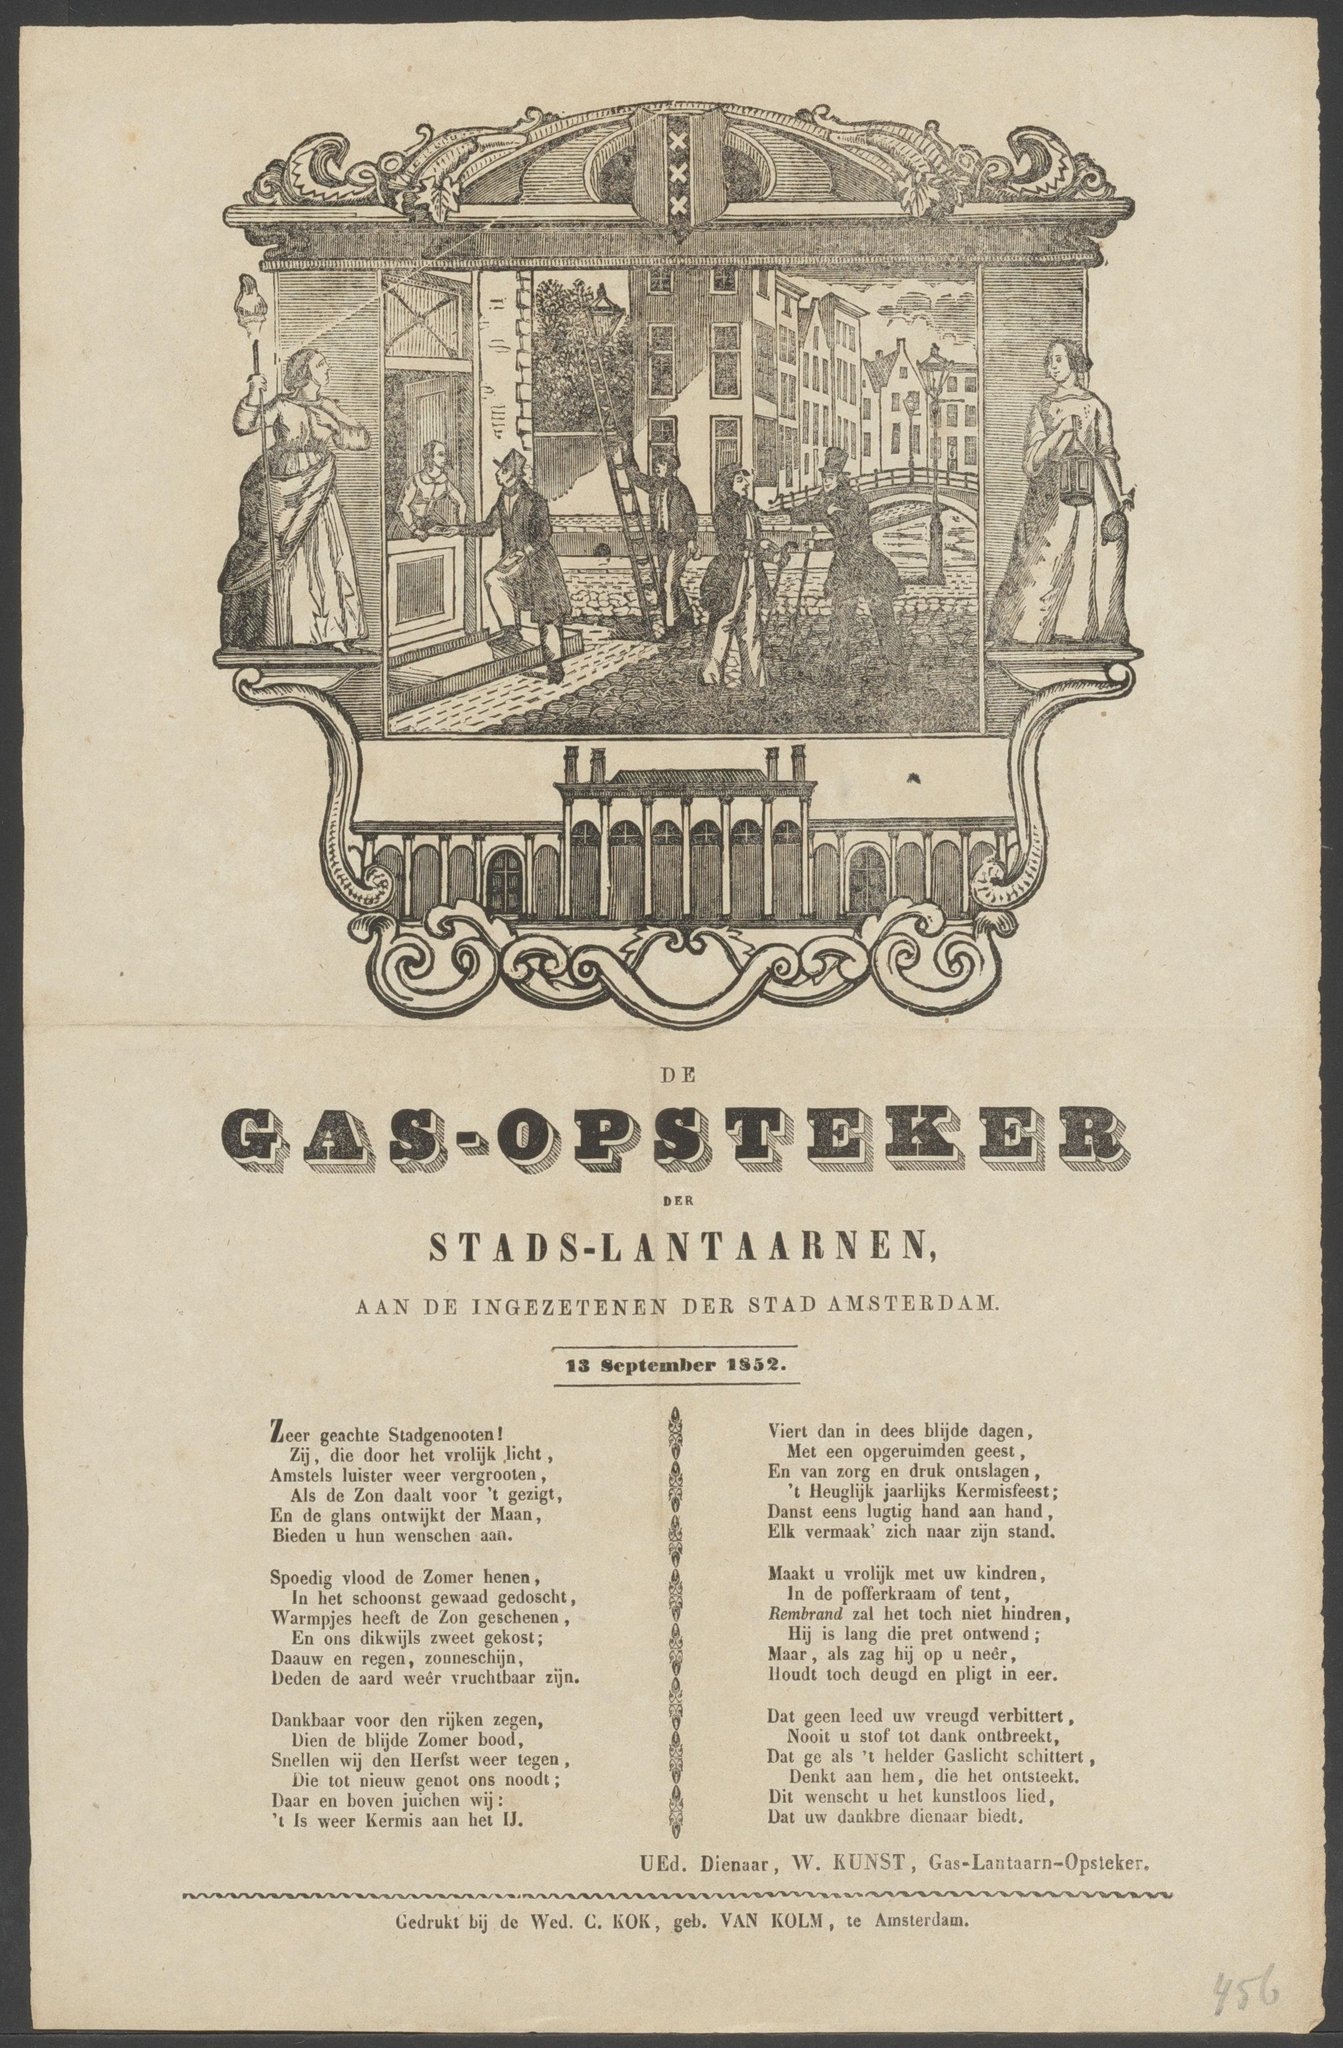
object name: print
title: De Schoonhouder en opsteker der Stads-Lantaarnen, aan de ingezetenen der stad Amsterdam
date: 1852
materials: paper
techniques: letterpress printing, engraving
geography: amsterdam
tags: gas-lamp, street lighting, amsterdam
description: Kermiswens van de Amsterdamse gaslantaarnopstekers voor het jaar 1852. Cartouche met een gezicht in een straat in Amsterdam waar enkele mannen bezig zijn de straatlantaarns aan te steken. Een andere man haalt geld op bij een huis. Links en rechts een staande vrouw met een fakkel en een olielantaarn, onderaan de Amsterdamse gasfabriek. Met gedicht in drie kolommen. Van de gaslantaarnopsteker: W. Kunst. Onderwerpsrubrieken binnen de Atlas Zeden en Gewoonten: Zeden en gewoonten in engeren zin, Volksleven, Volksbladen, Nieuwjaars- en Kerstwenschen, Amsterdam.